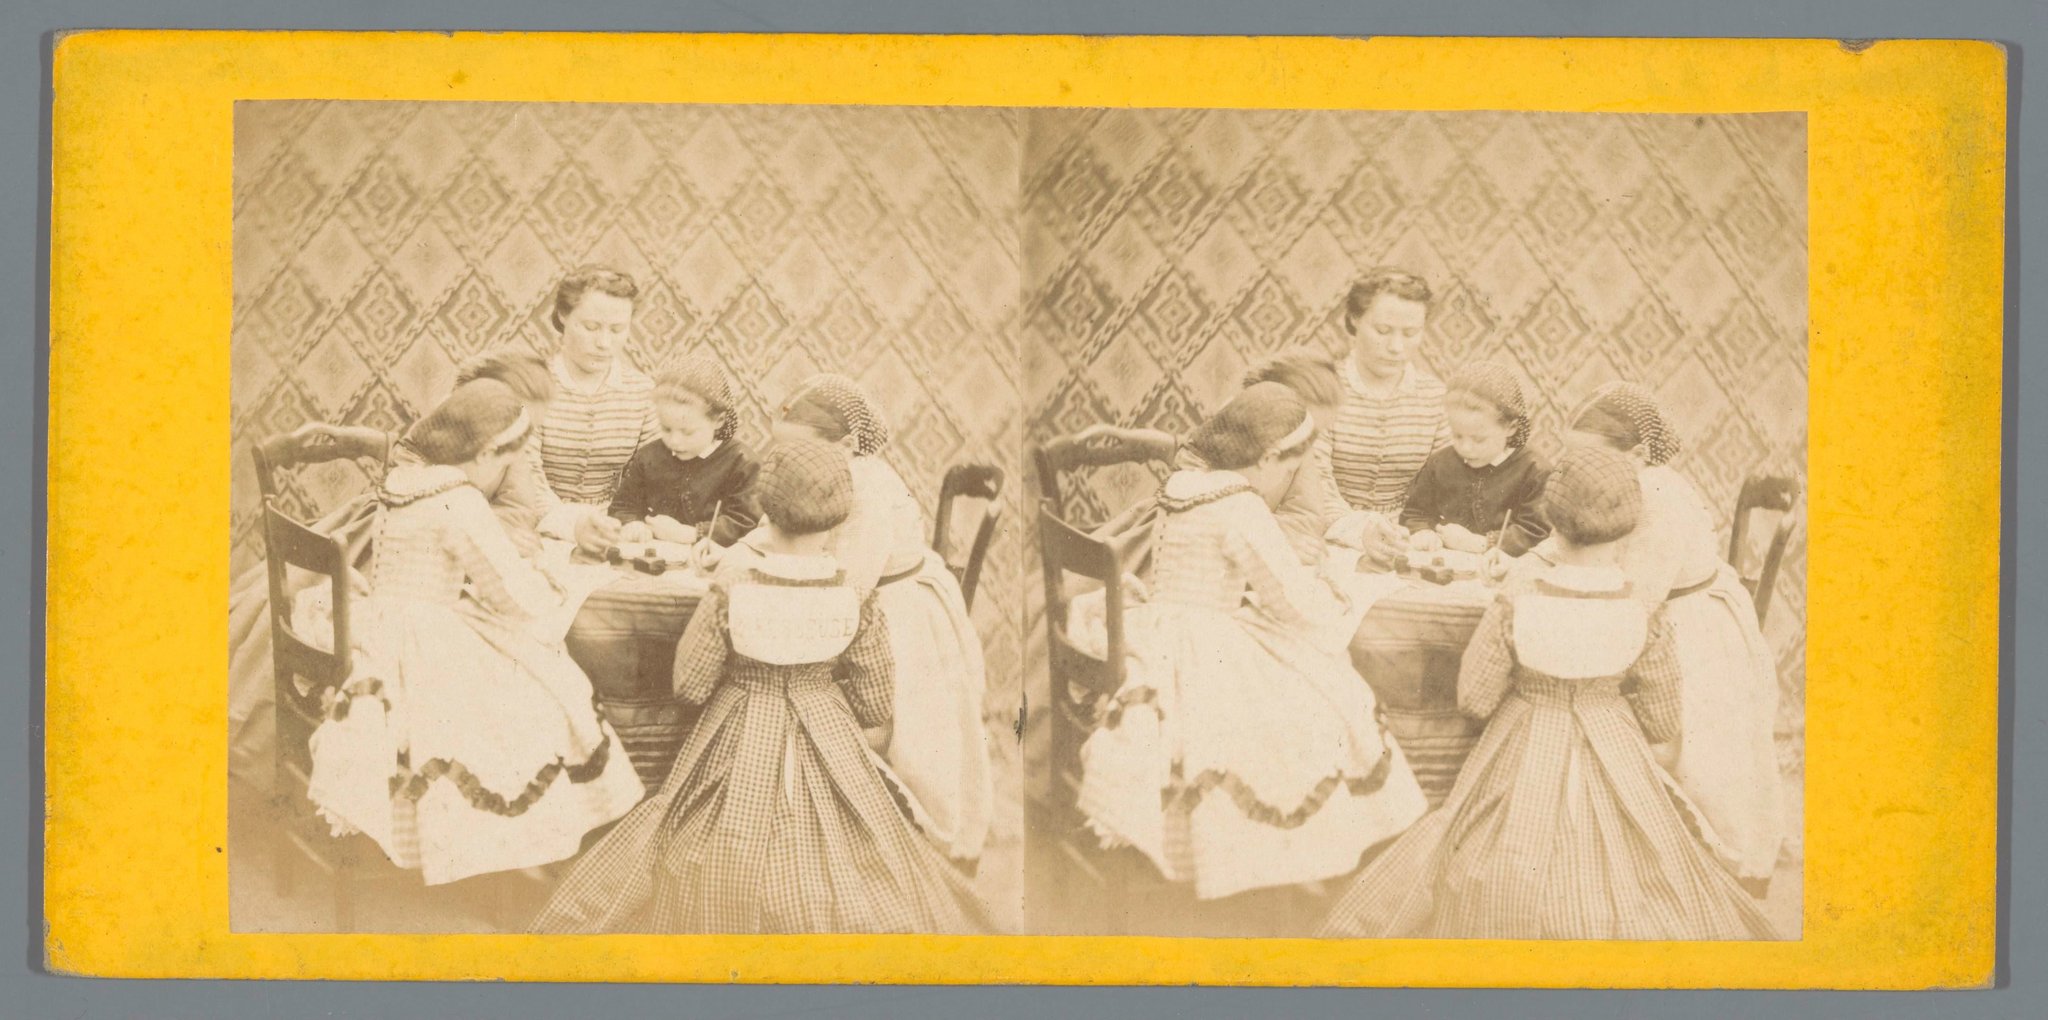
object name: stereograph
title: Vrouw met spelende kinderen rond een tafel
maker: Anonymous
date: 1850-1880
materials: cardboard, photographic support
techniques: albumen print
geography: europe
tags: sitting figure, children's games and plays, europe